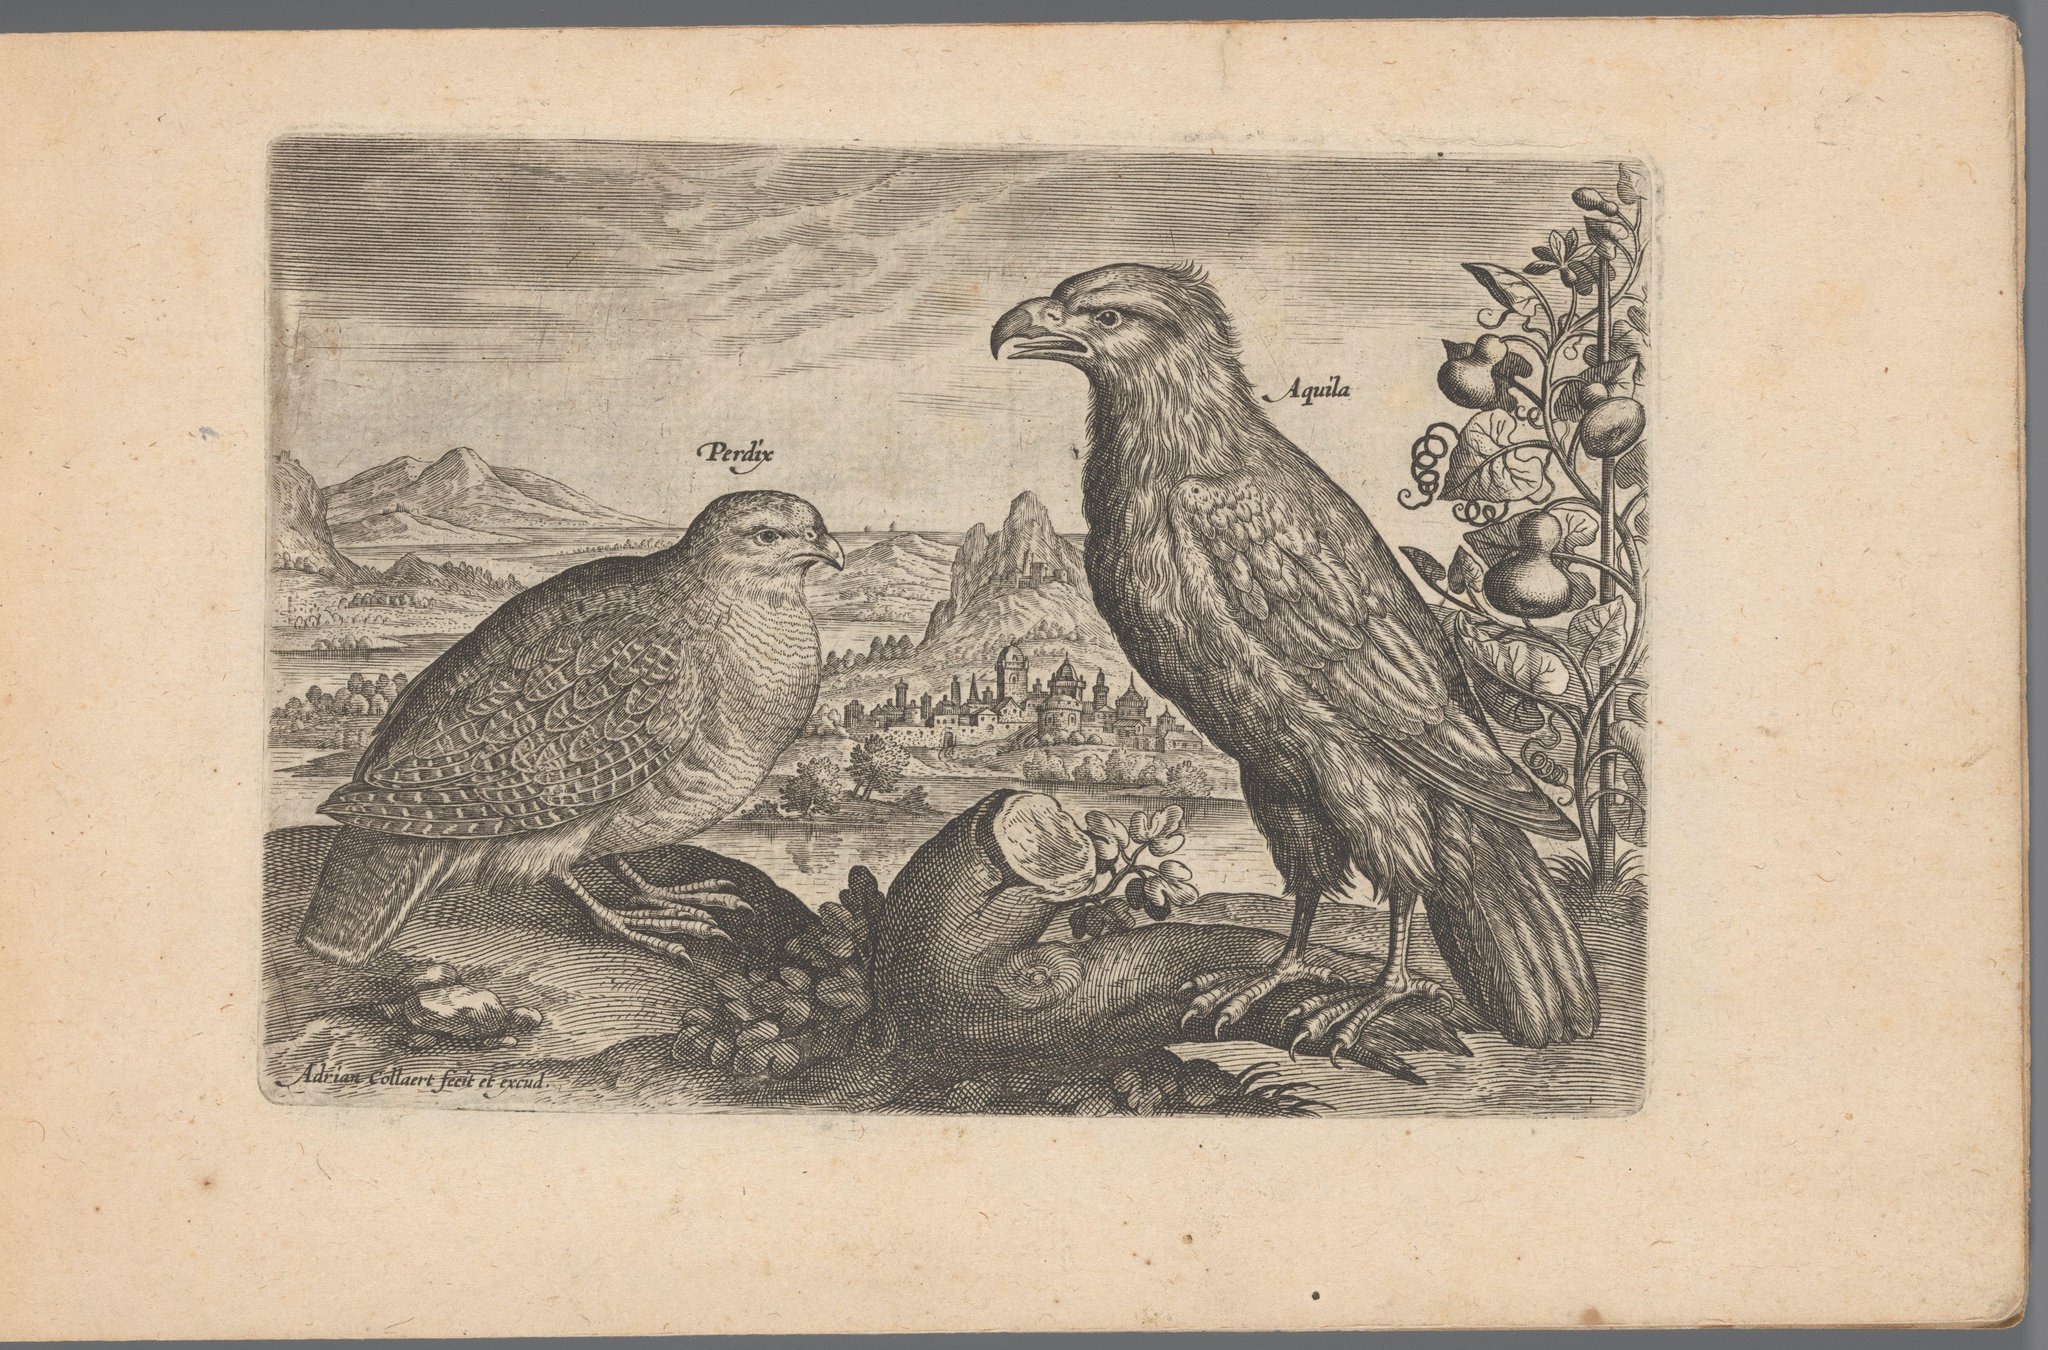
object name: print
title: Avium Vivae Icones in aes incisae & edita ab Adriano Collardo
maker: adriaen collaert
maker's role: draughtsman, print maker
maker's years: 1560-1618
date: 1570-1600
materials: paper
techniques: engraving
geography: antwerp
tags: predatory birds: eagle, walker and runner birds: partridge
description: Een patrijs en een adelaar in een landschap. Prent is onderdeel van een prentalbum met zeven prenten van vogels en de titelprent.